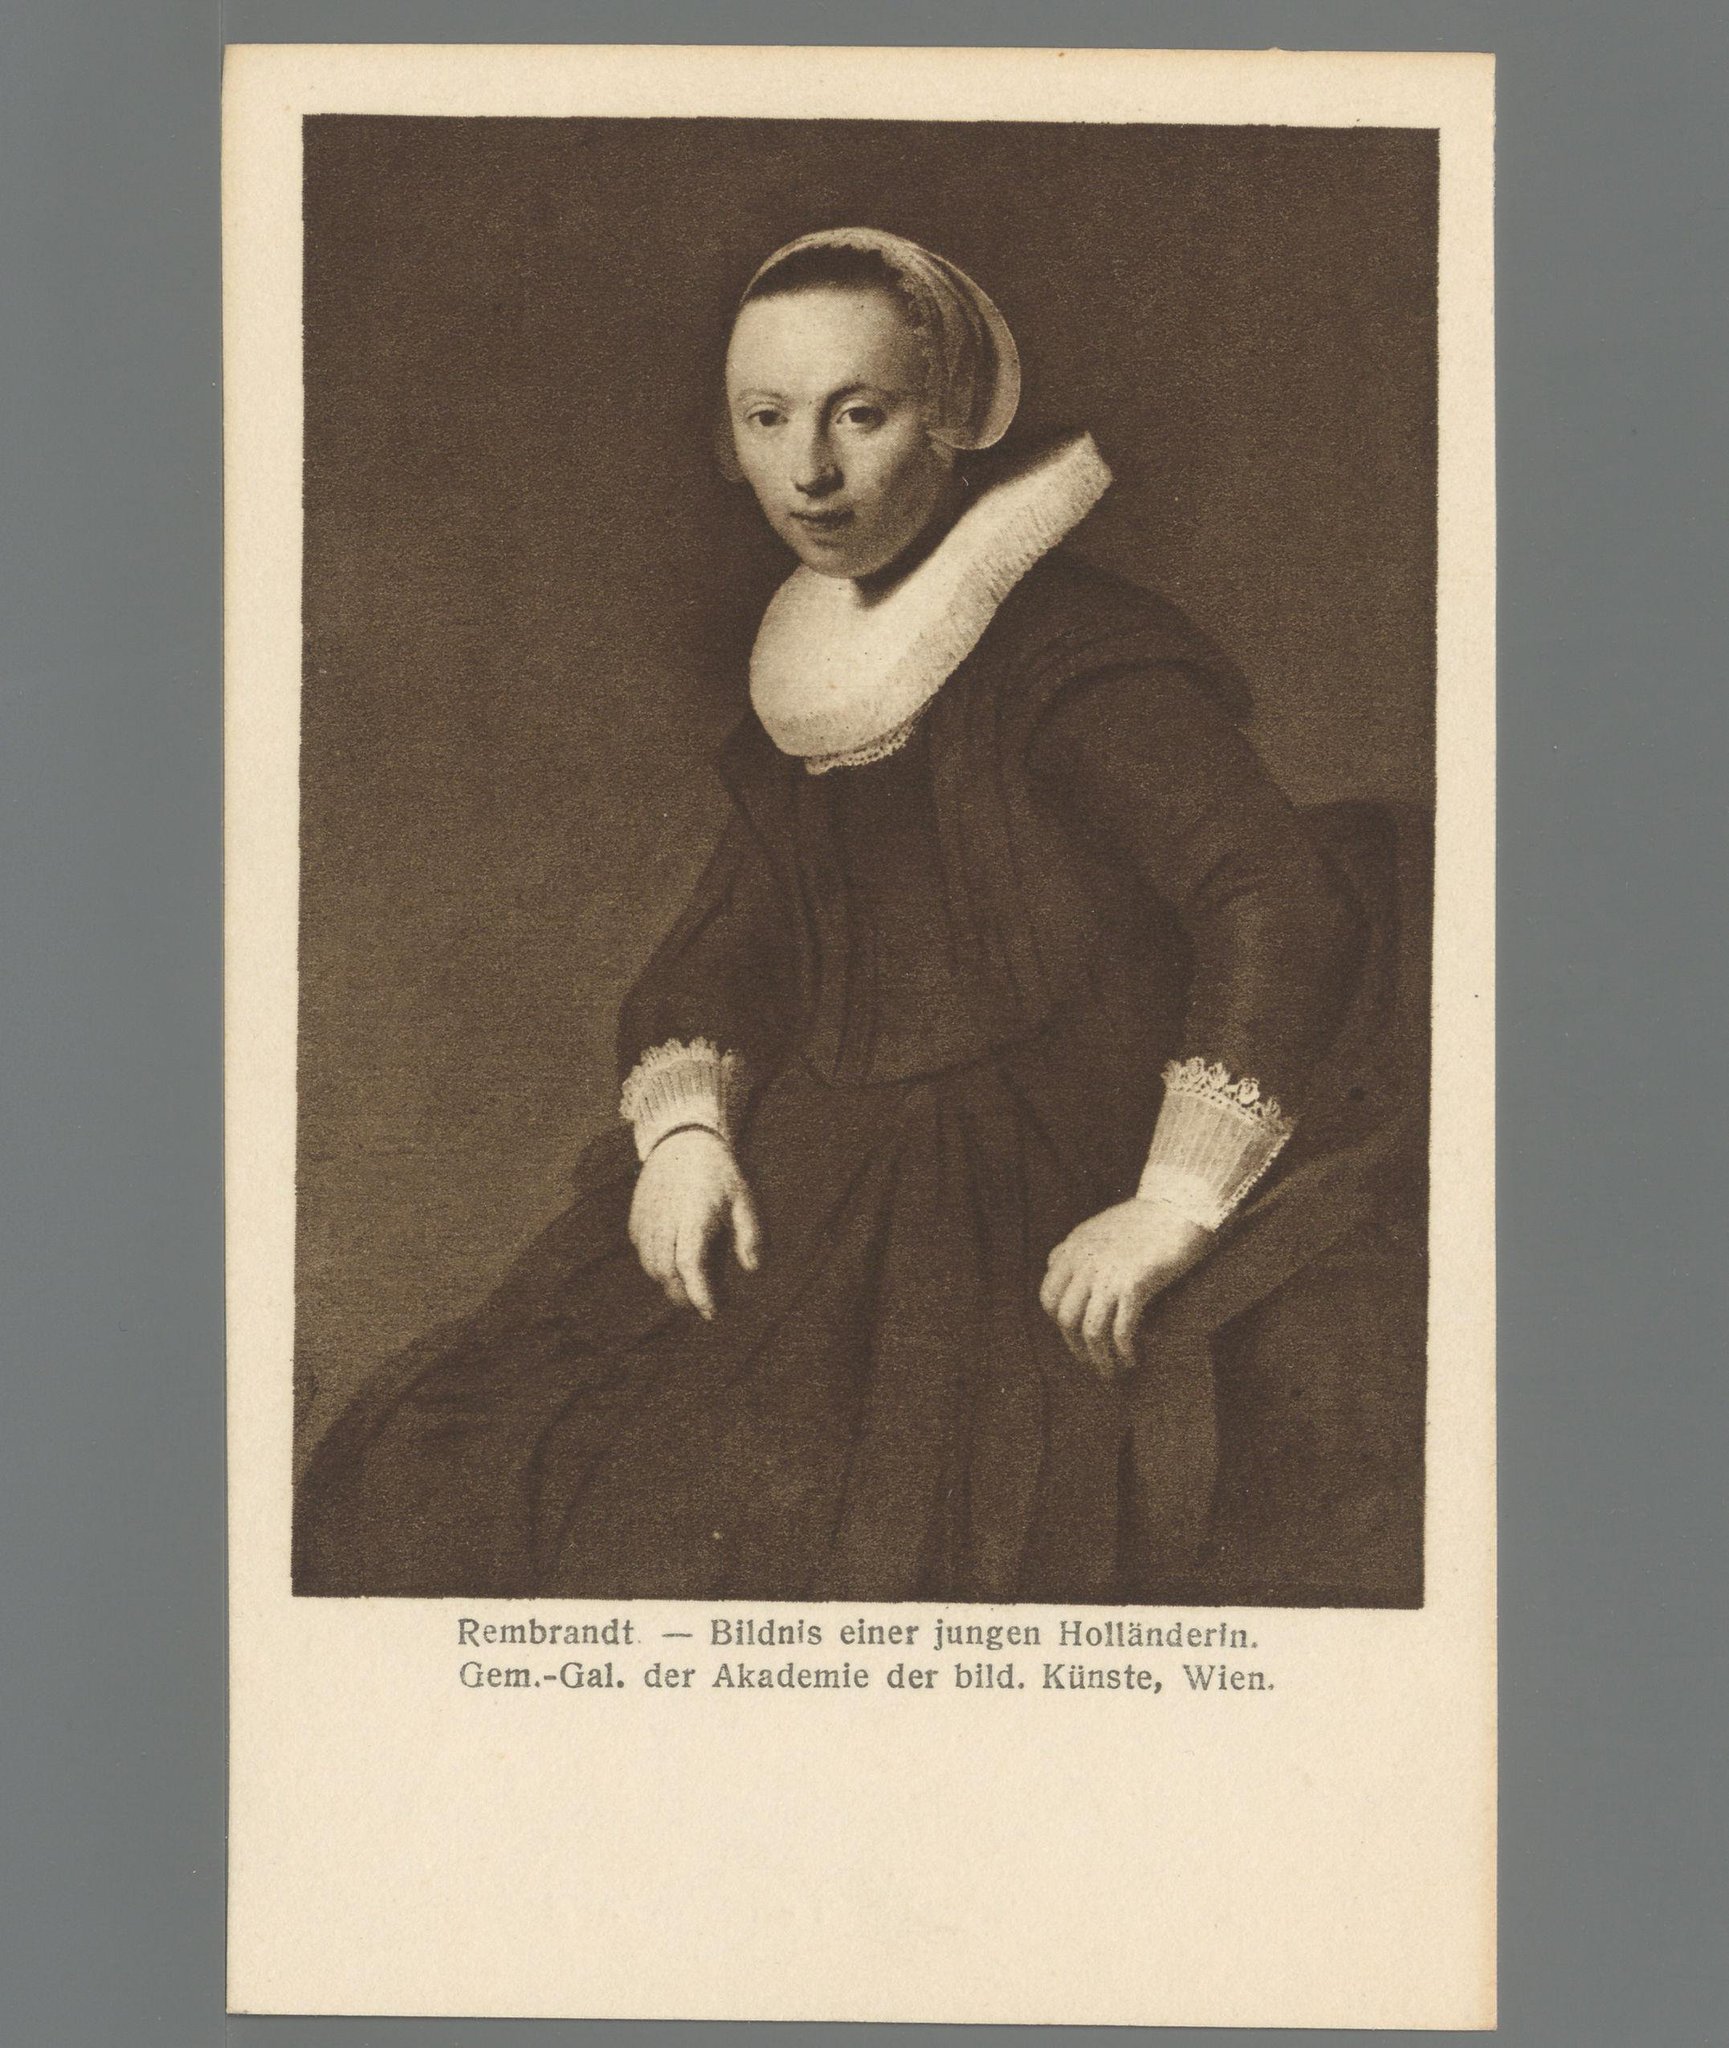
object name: reproduction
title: Rembrandt. Bildnis einer jungen Holländerin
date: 1905-1930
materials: cardboard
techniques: rotogravure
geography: vienna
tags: adult woman (+ three-quarter view), lace